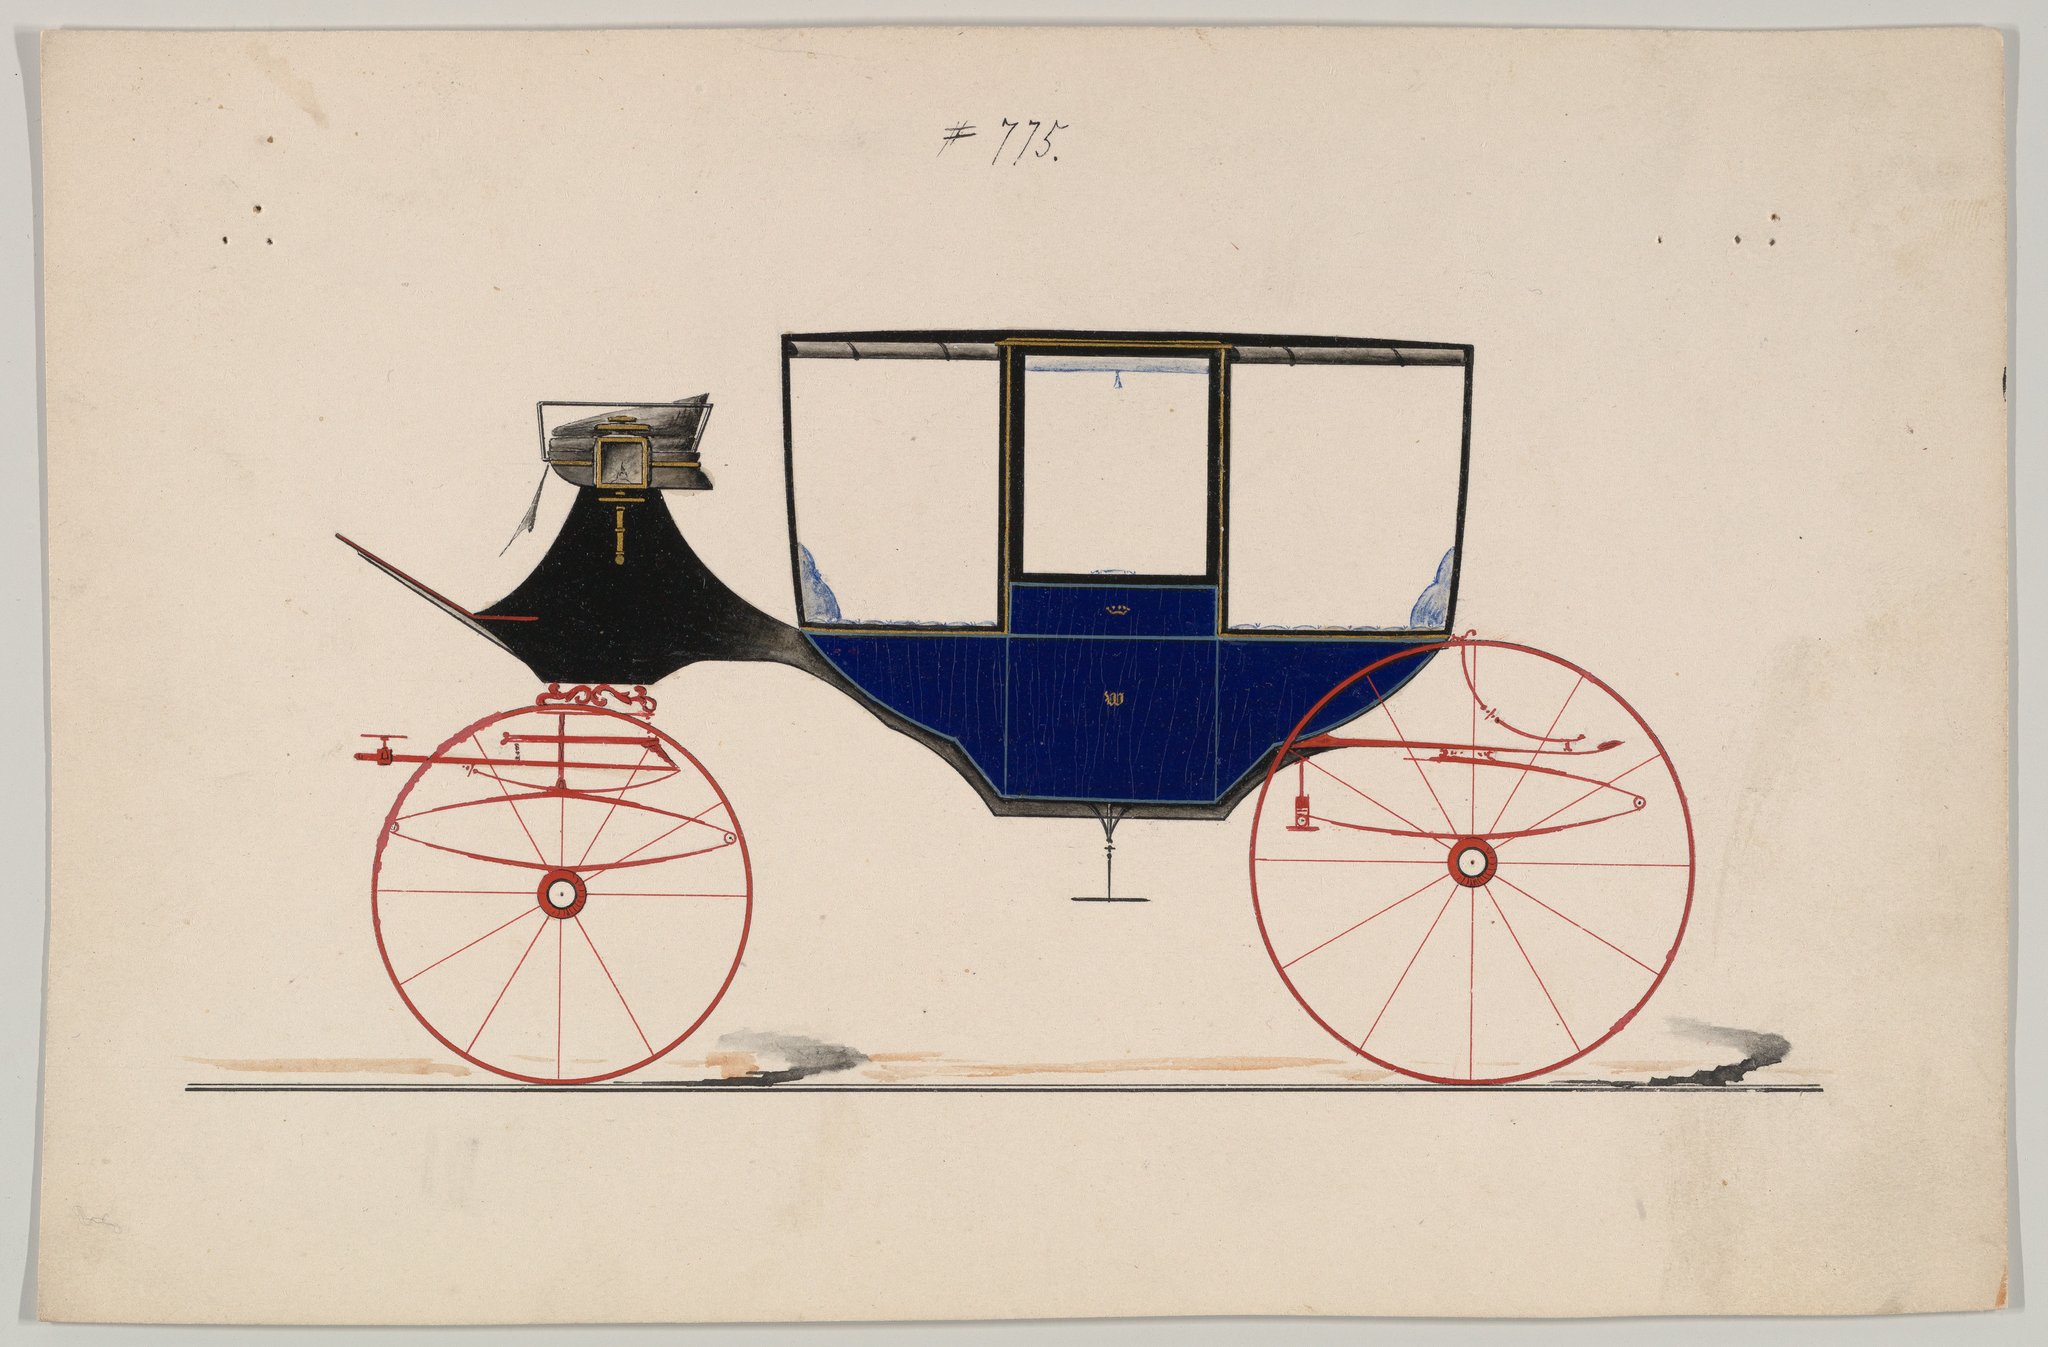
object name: drawing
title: Curtain Coach #775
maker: brewster & co.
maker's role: manufacturer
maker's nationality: american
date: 1865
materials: gouache, gum arabic, ink, watercolor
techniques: pen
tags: carriages